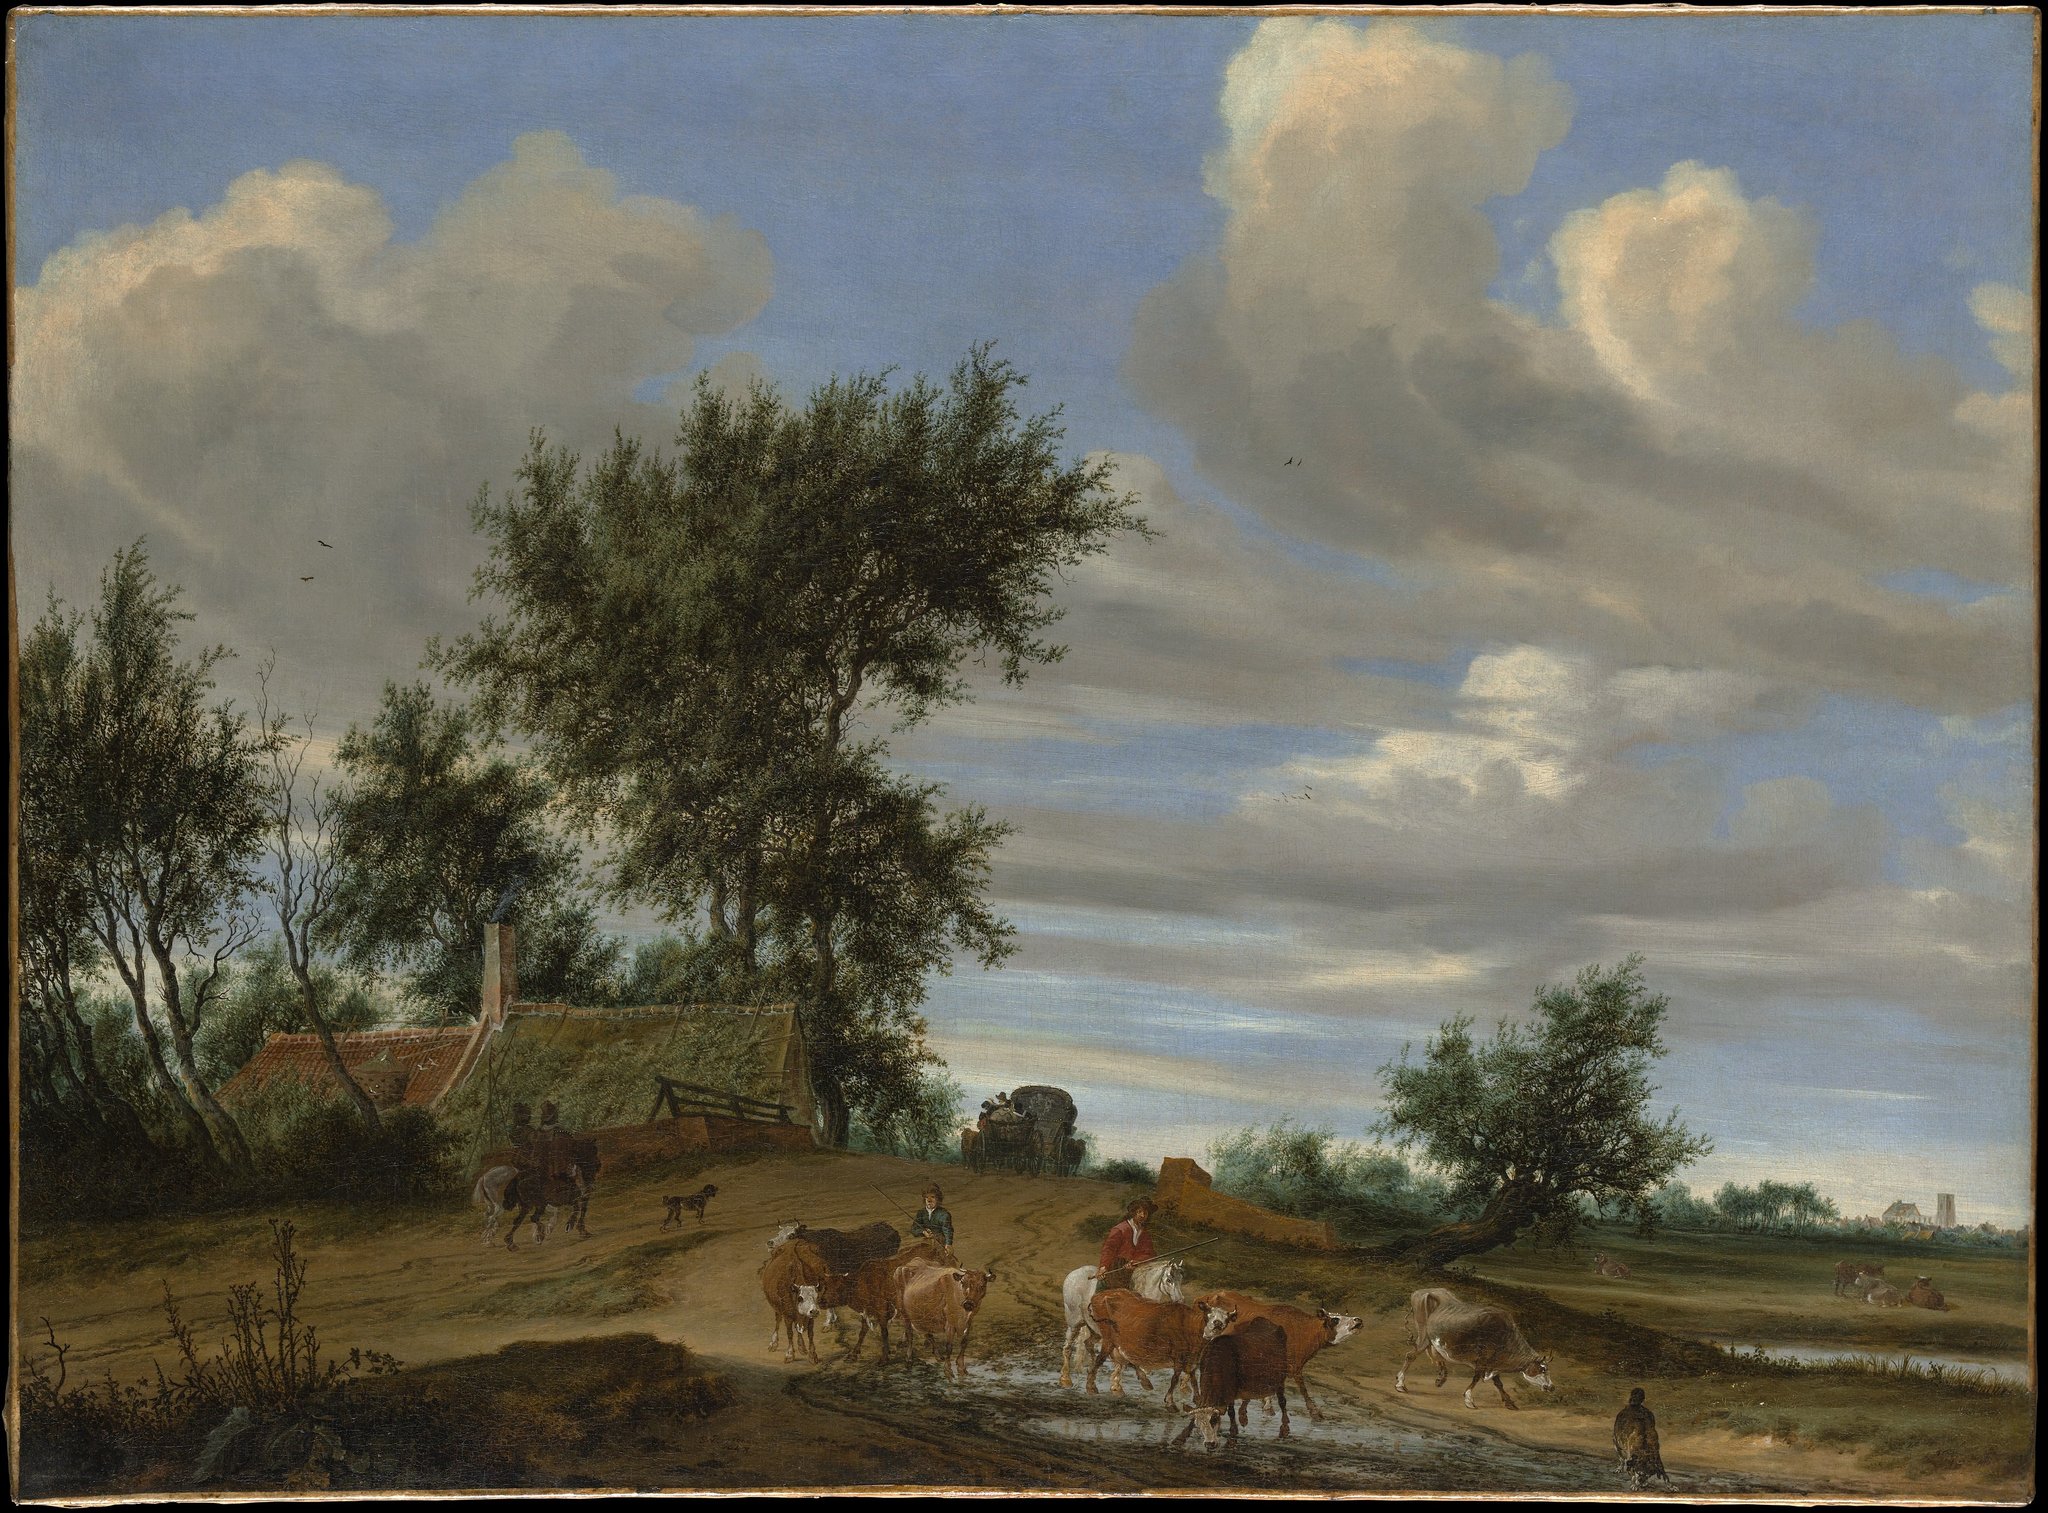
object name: painting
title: A Country Road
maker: salomon van ruysdael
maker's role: artist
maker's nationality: dutch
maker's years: 1600-1670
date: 1648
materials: canvas, oil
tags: roads,cows,landscapes